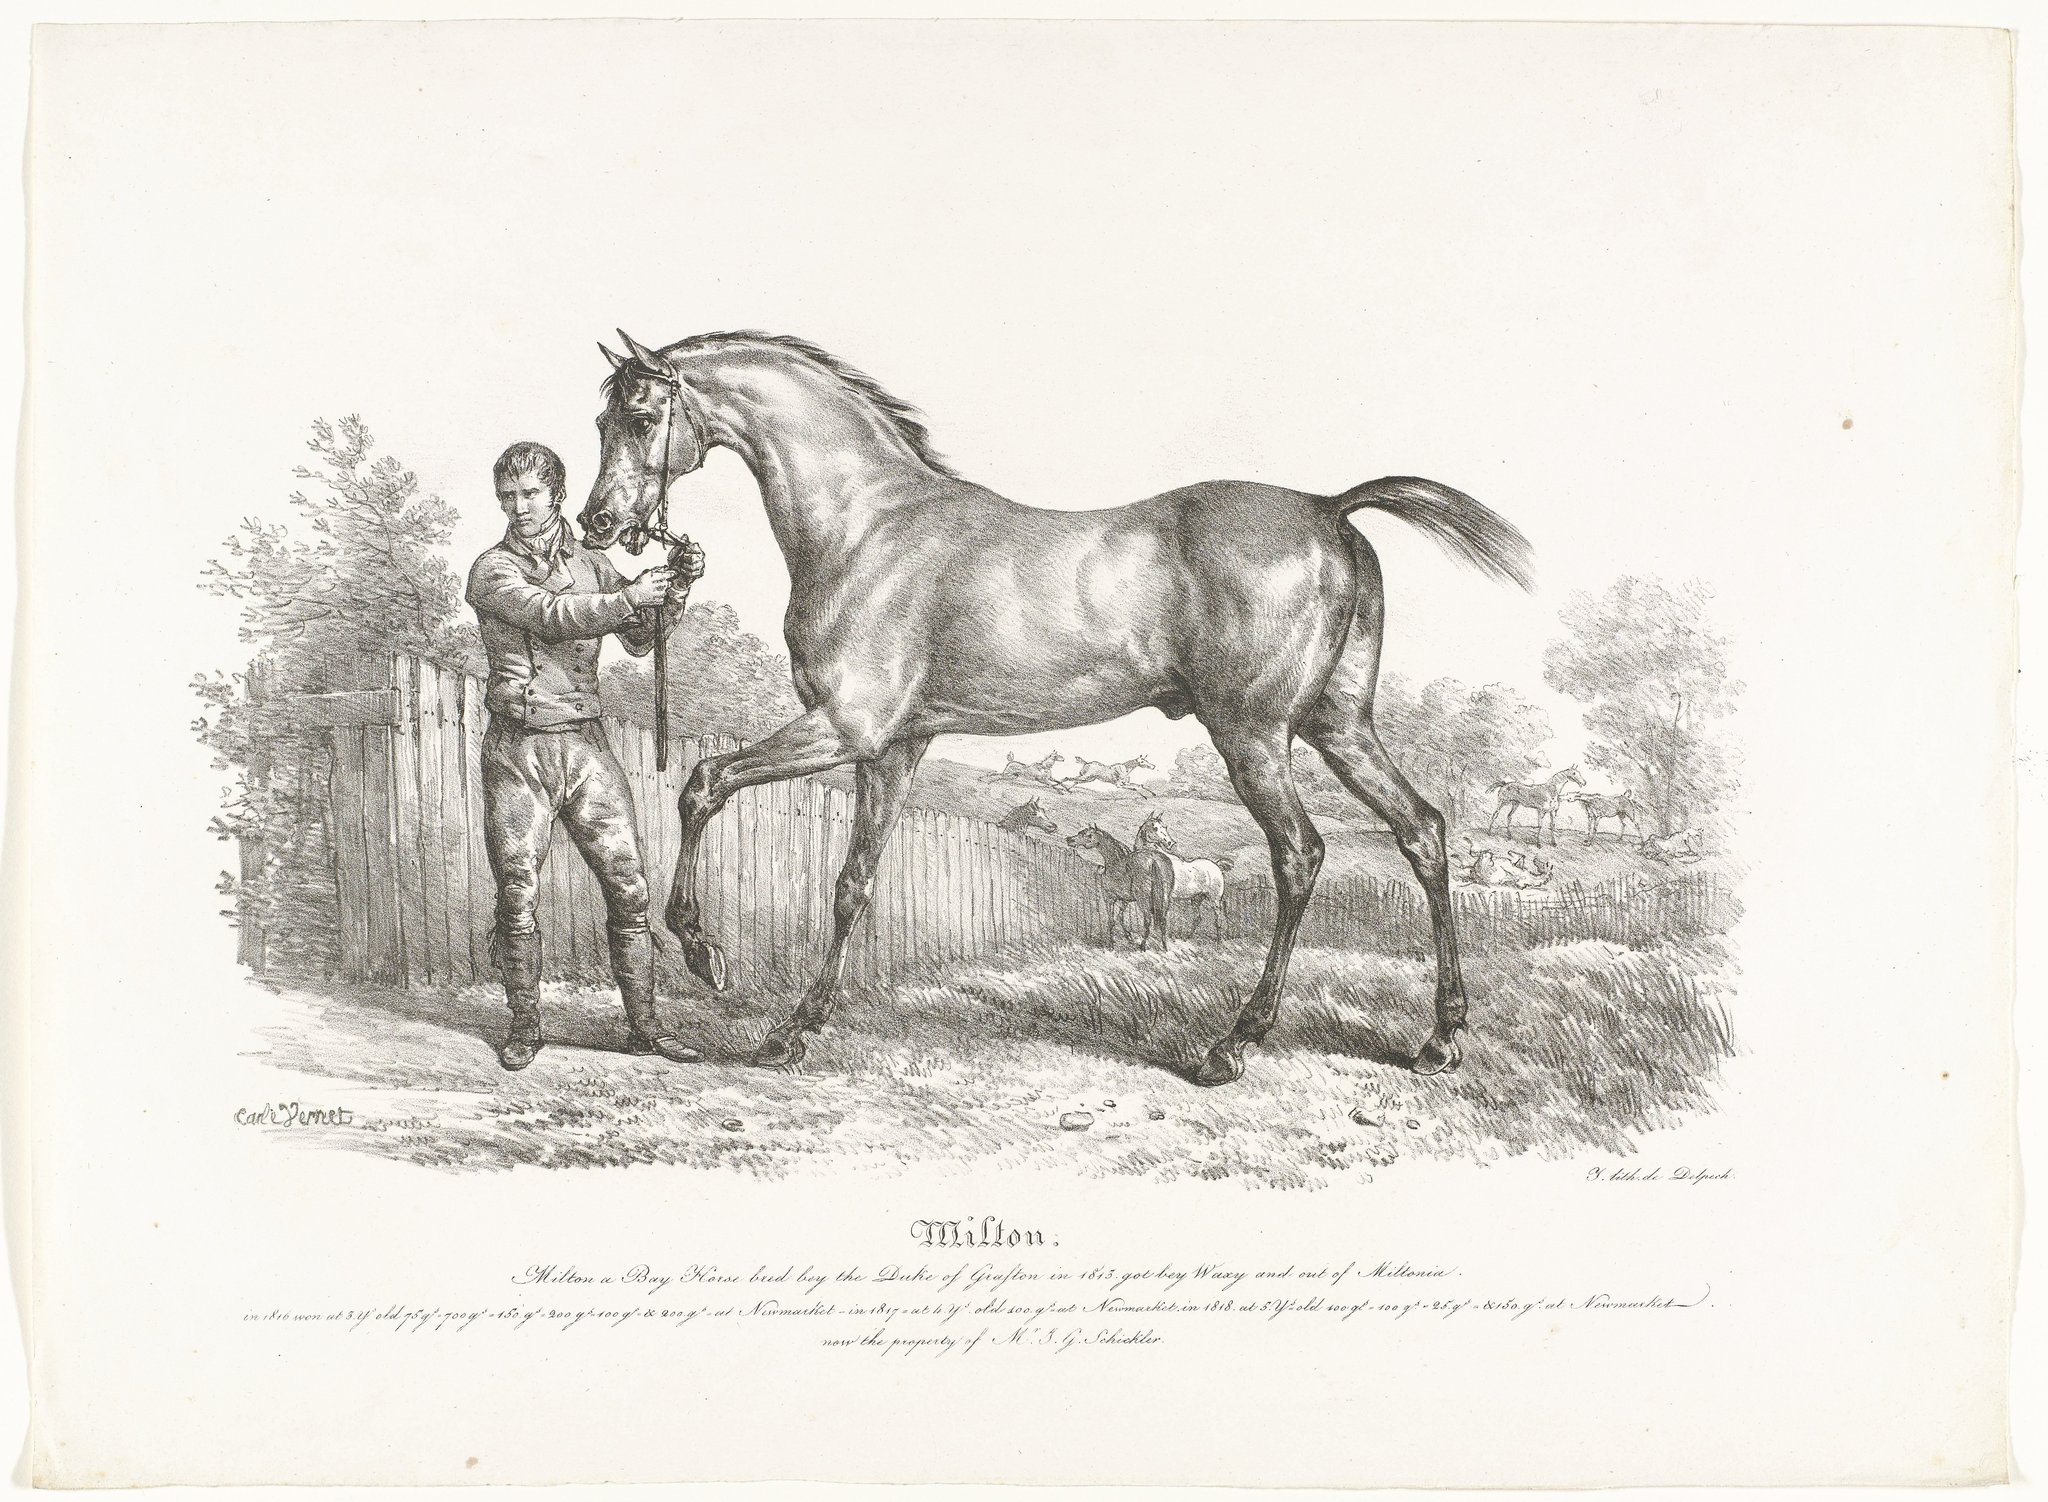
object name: print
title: Grote paardenserie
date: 1822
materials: paper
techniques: lithograph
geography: paris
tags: horse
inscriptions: collector's mark: Lugt 2228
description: Het volgnummer van deze prent in de serie van 57 prenten is onbekend.